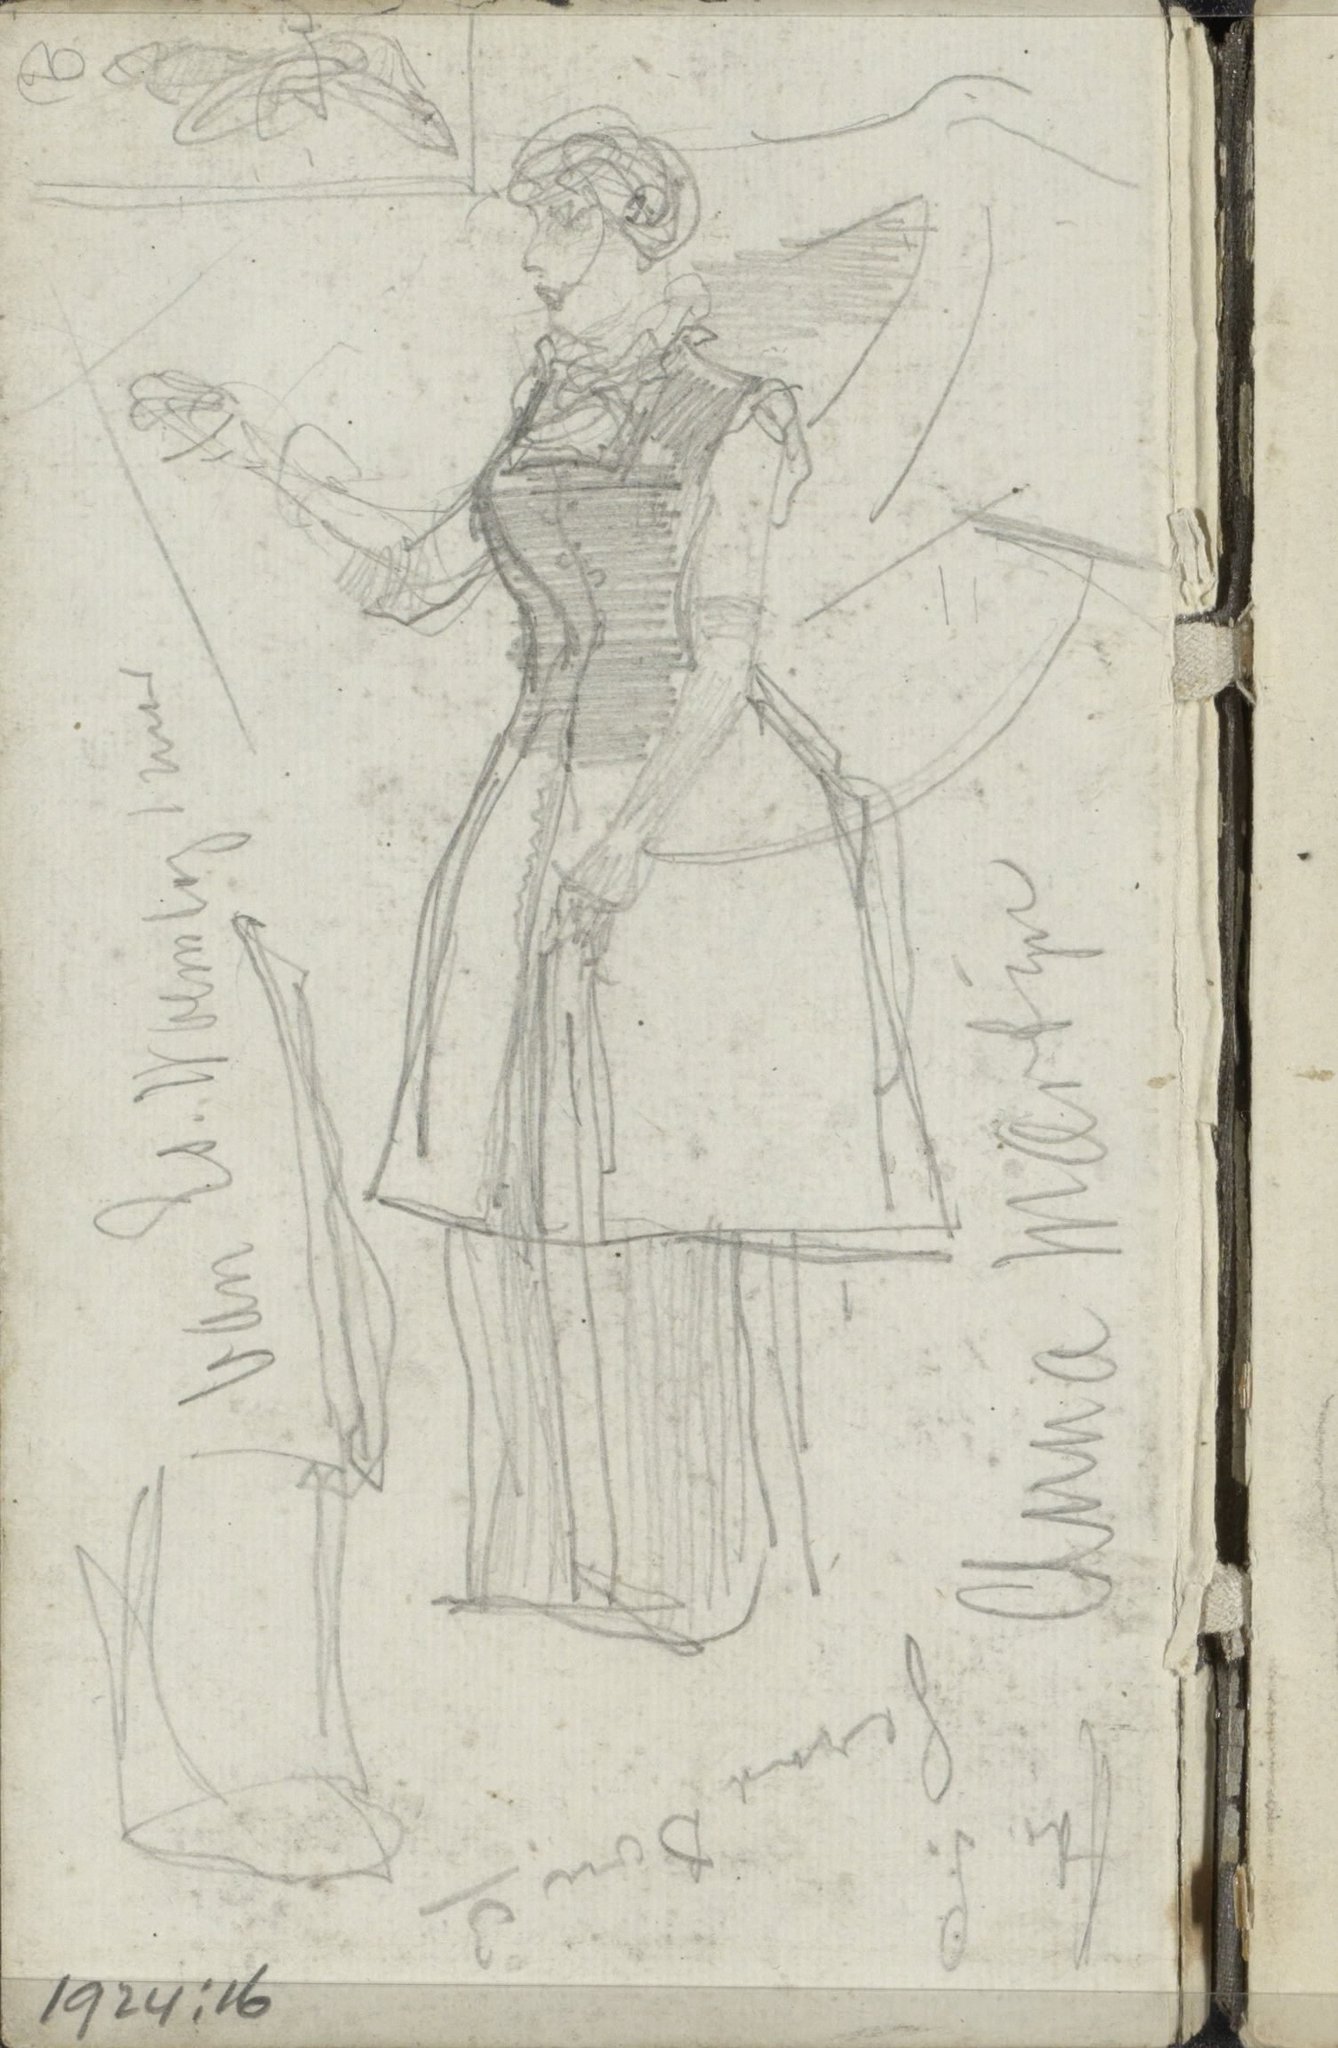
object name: endleaf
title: Staande vrouw met opgeheven arm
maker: george hendrik breitner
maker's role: draughtsman, painter, print maker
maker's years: 1857-1923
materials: paper, pencil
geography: the hague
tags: arm raised upward, standing figure - aa - female human figure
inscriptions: annotation: ‘Van Es. Woensdag 1 uur/ Anna Martijn’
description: Pagina 1, voorste schutblad, uit een schetsboek met 28 bladen.